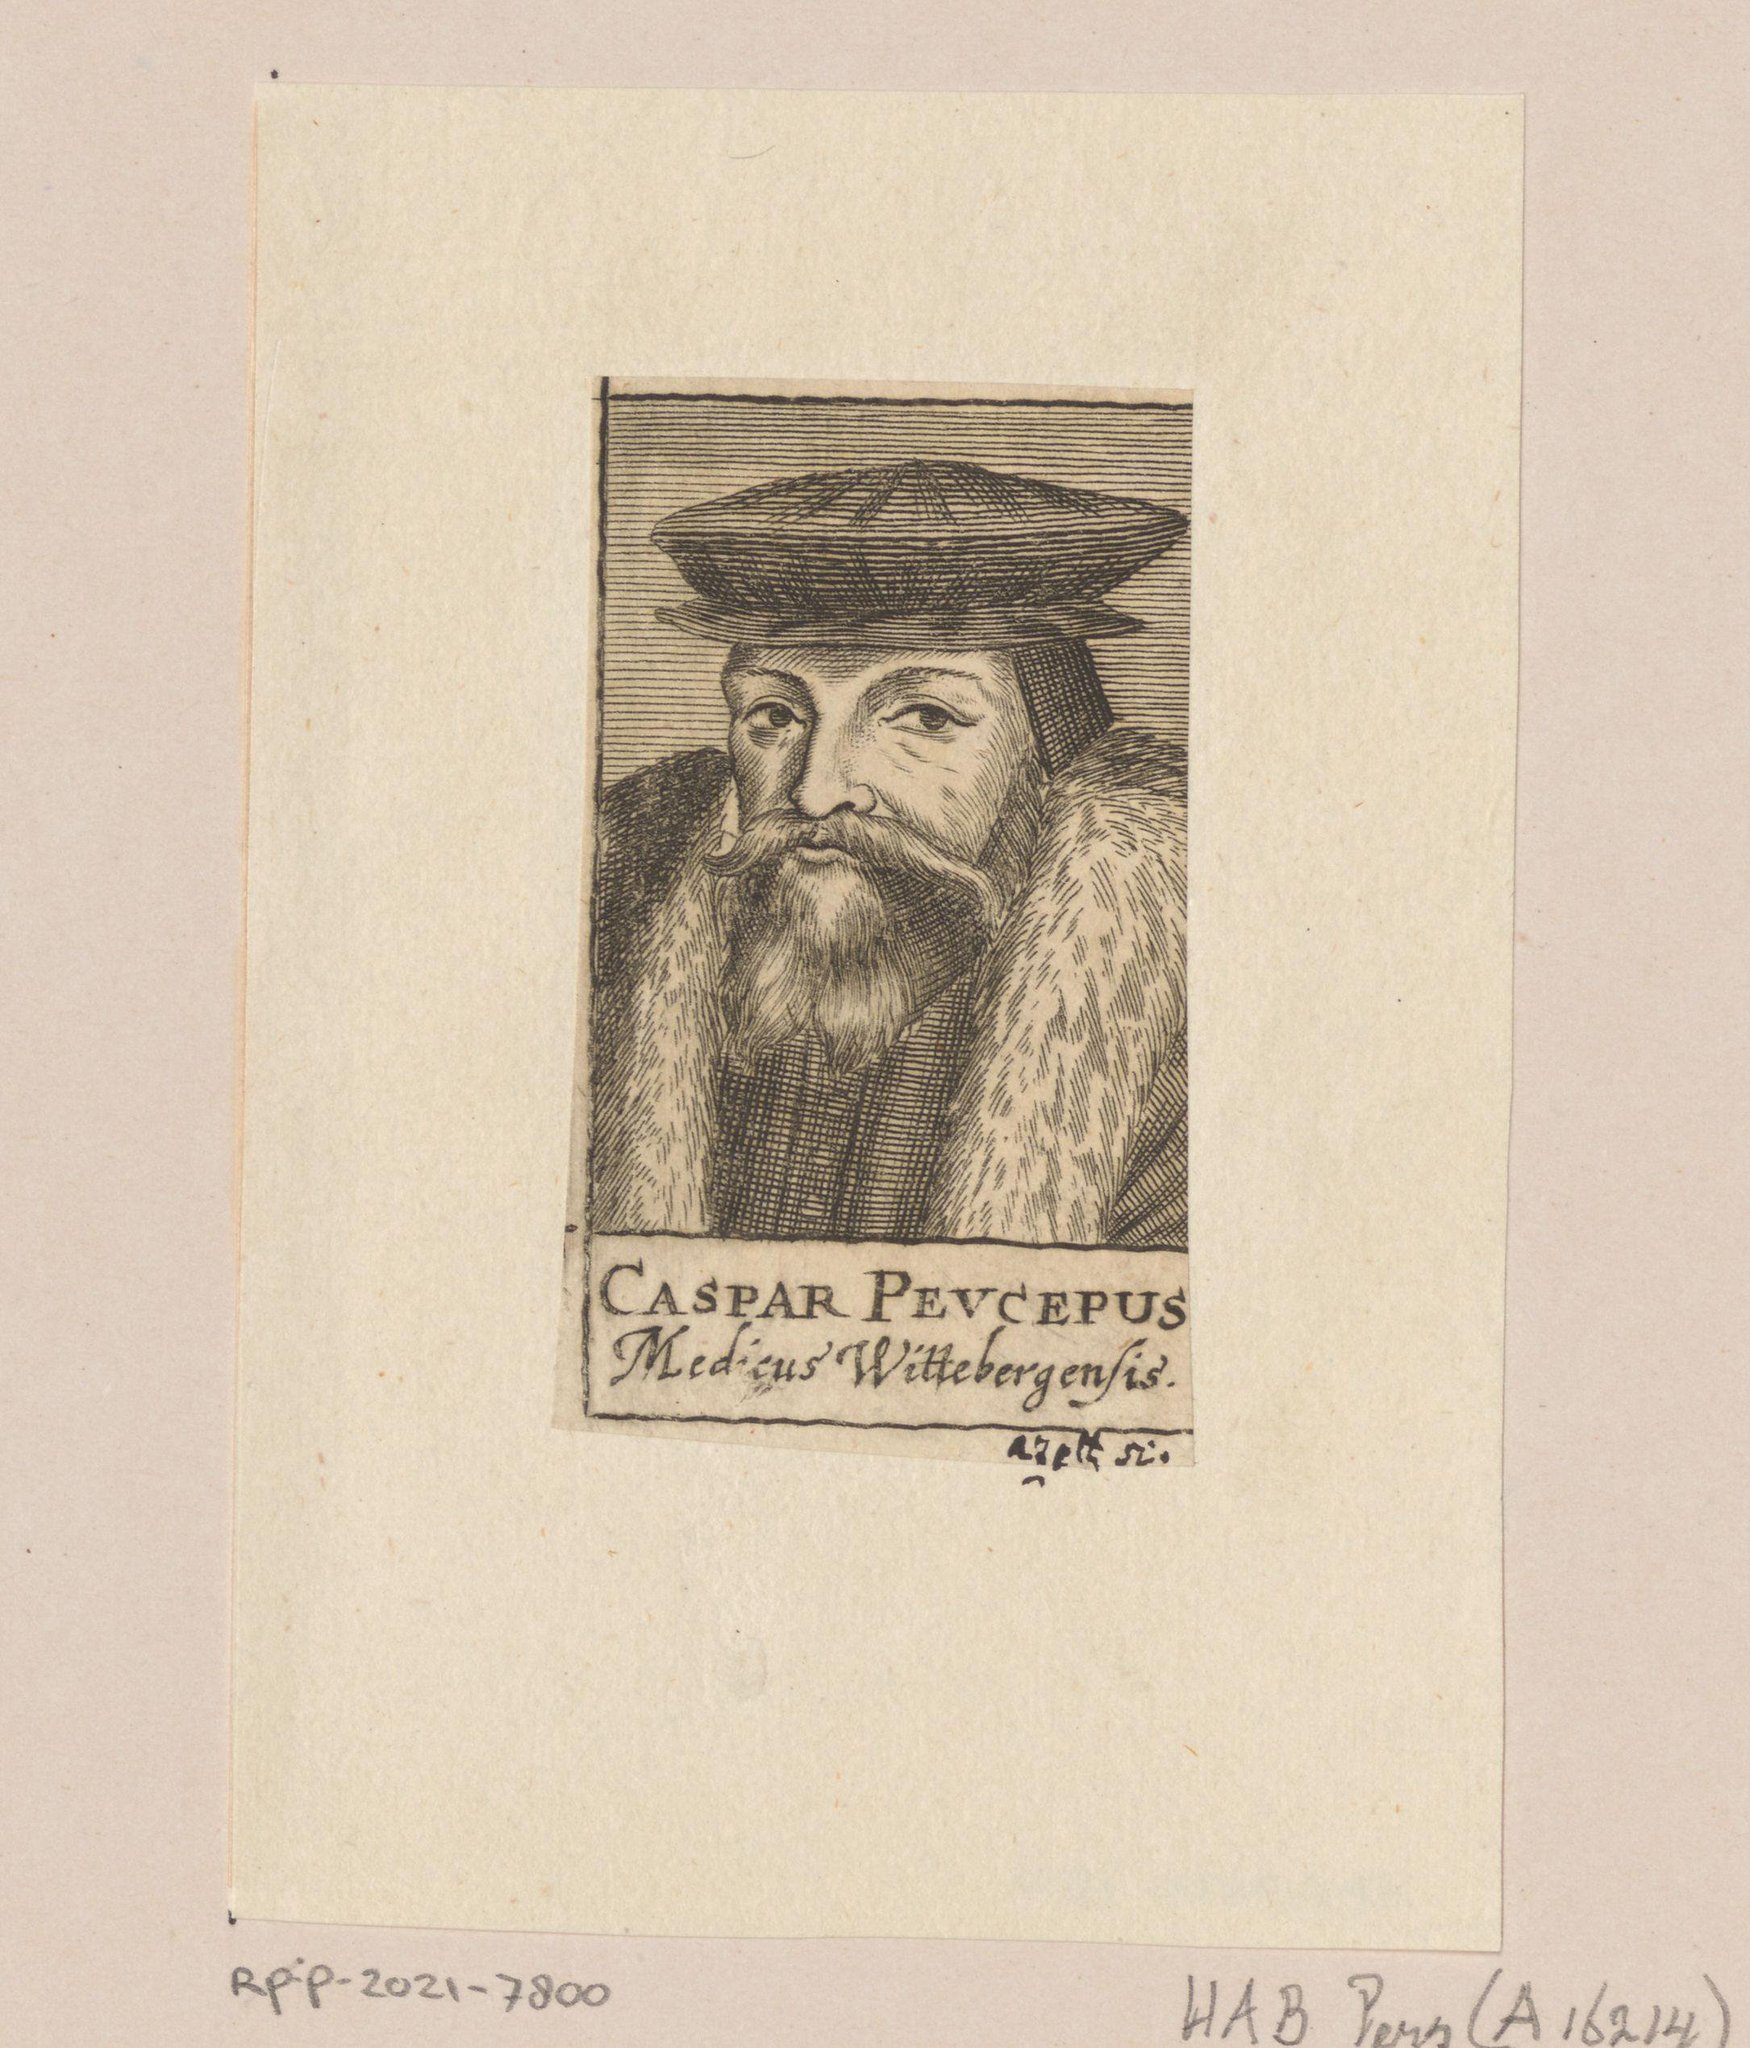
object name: print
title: Portret van Caspar Peucer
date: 1688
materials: paper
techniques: engraving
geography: nuremberg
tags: adult man, historical persons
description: Prent maakt deel uit van een grotere prent die later is verknipt. Prent uit: Freher, Paul. Theatrum virorum eruditione clarorum. Neurenberg: Johann Hoffmann, 1688.